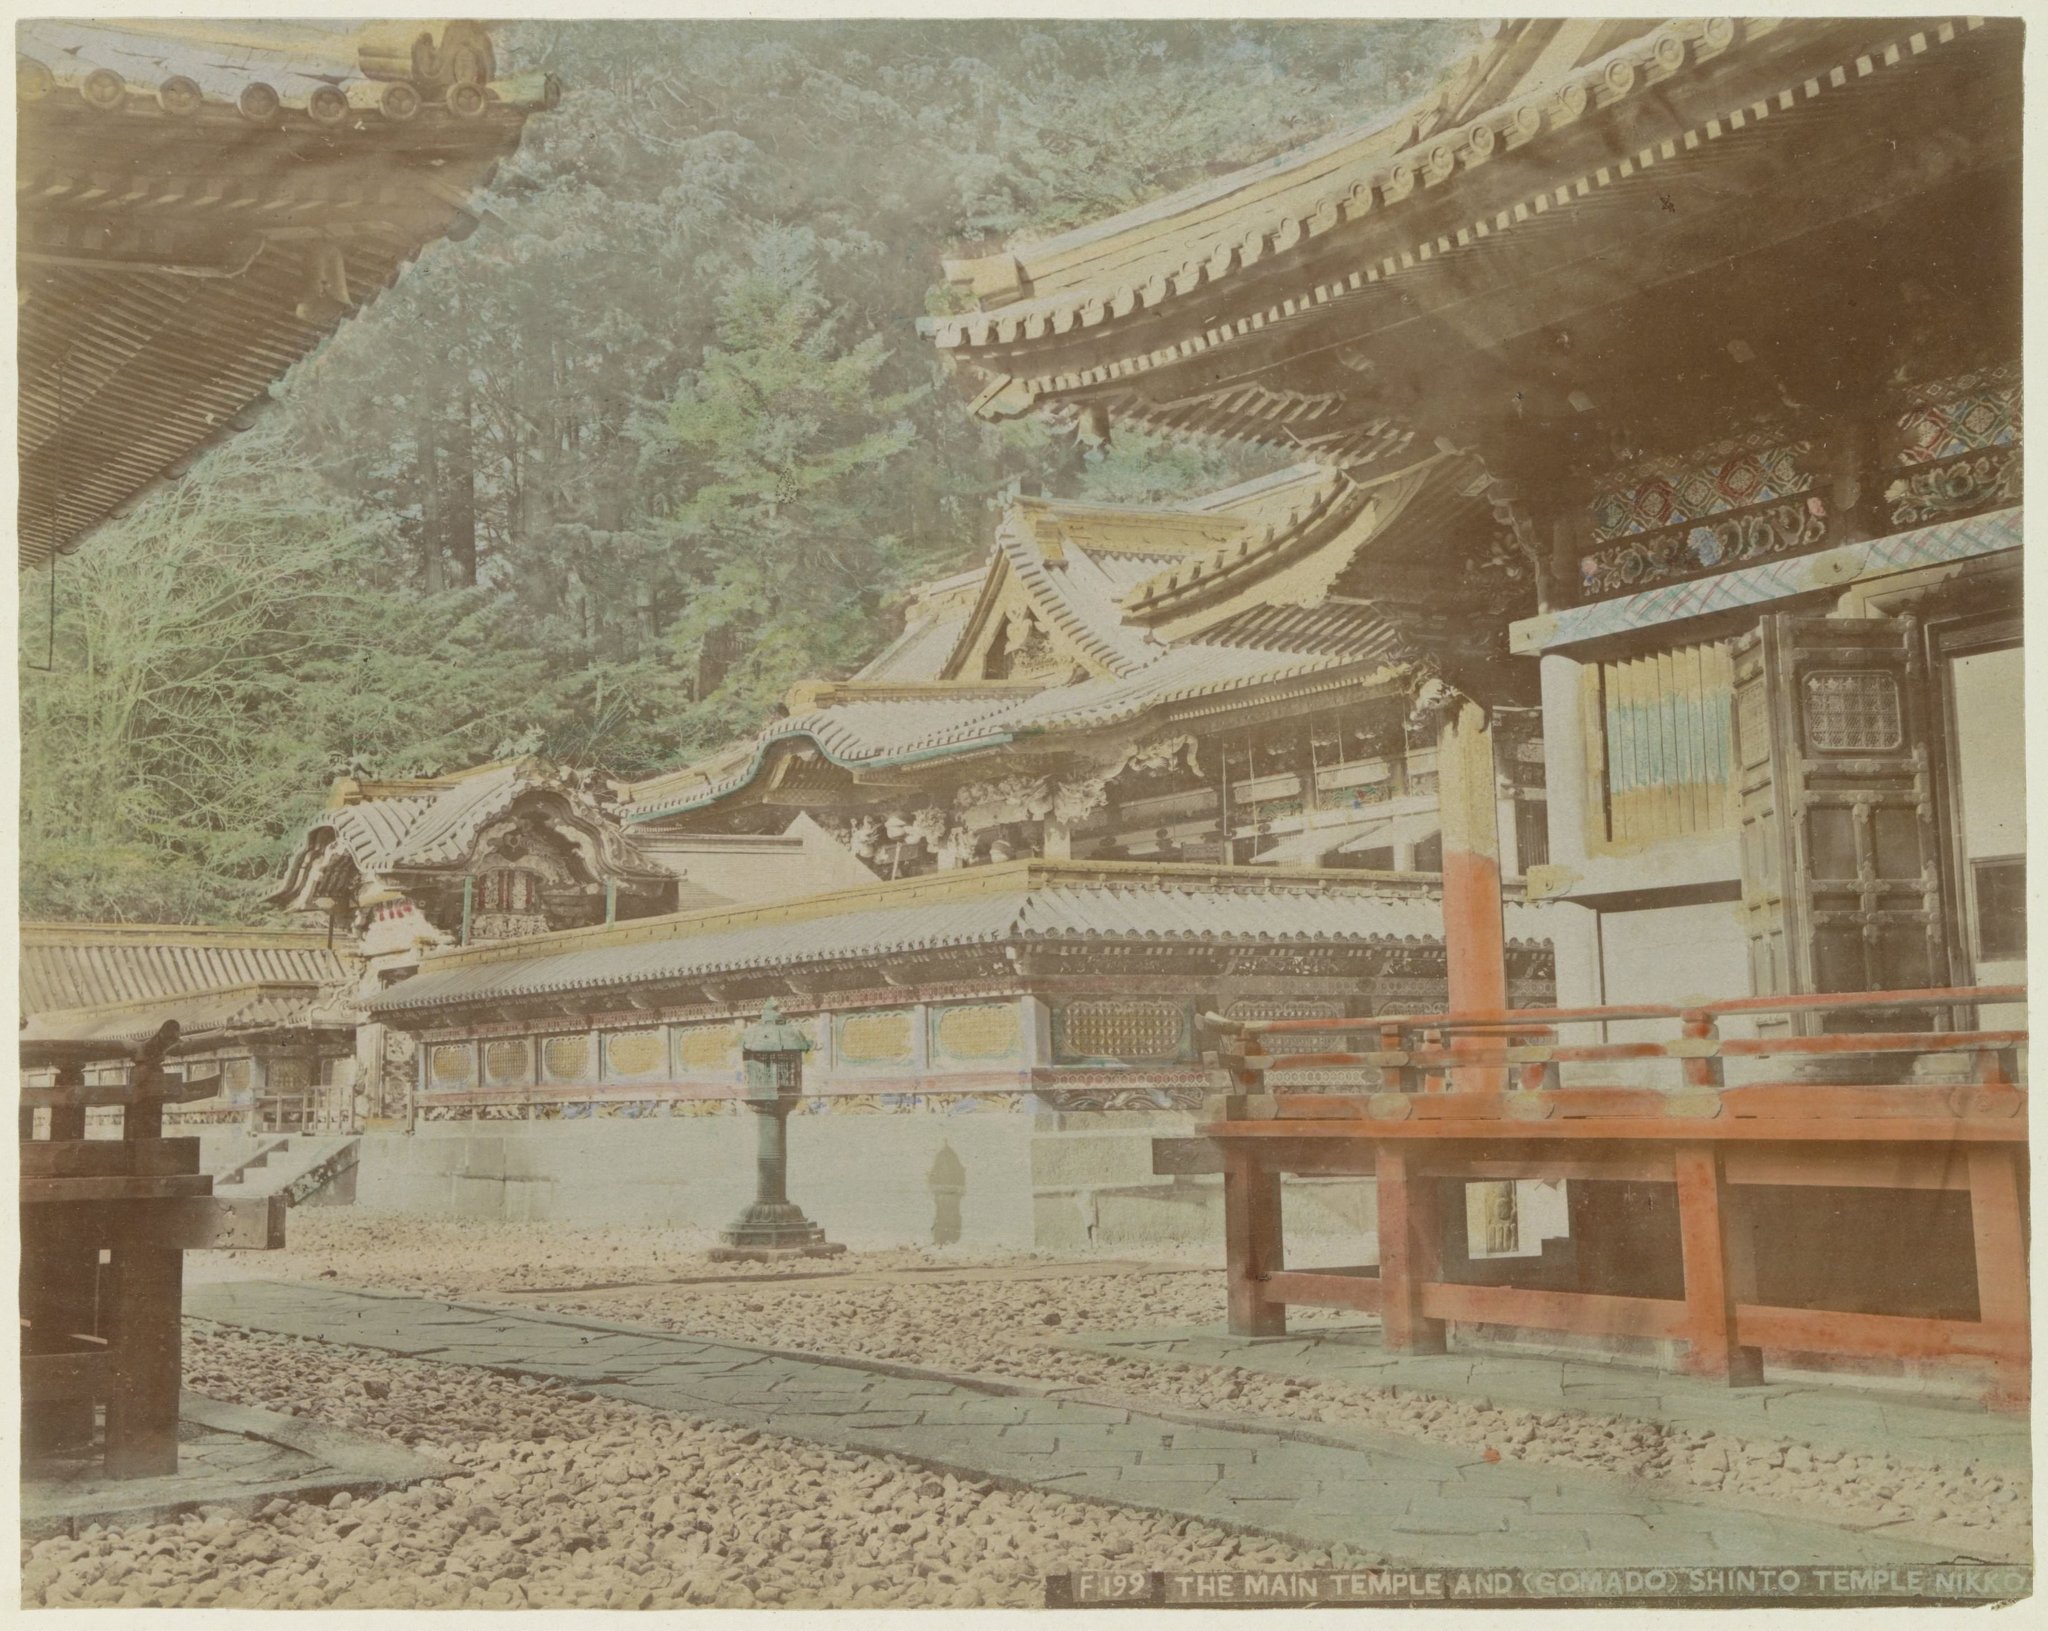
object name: photograph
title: Hoofdtempel en Gomado-tempel in Nikko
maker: Anonymous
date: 1870-1900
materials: cardboard, paper, photographic support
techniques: albumen print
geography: nikko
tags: temple, shrine ~ hinduism, buddhism, jainism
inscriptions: negative number: ‘F 199’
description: Onderdeel van Reisalbum met foto's van bezienswaardigheden in Japan.